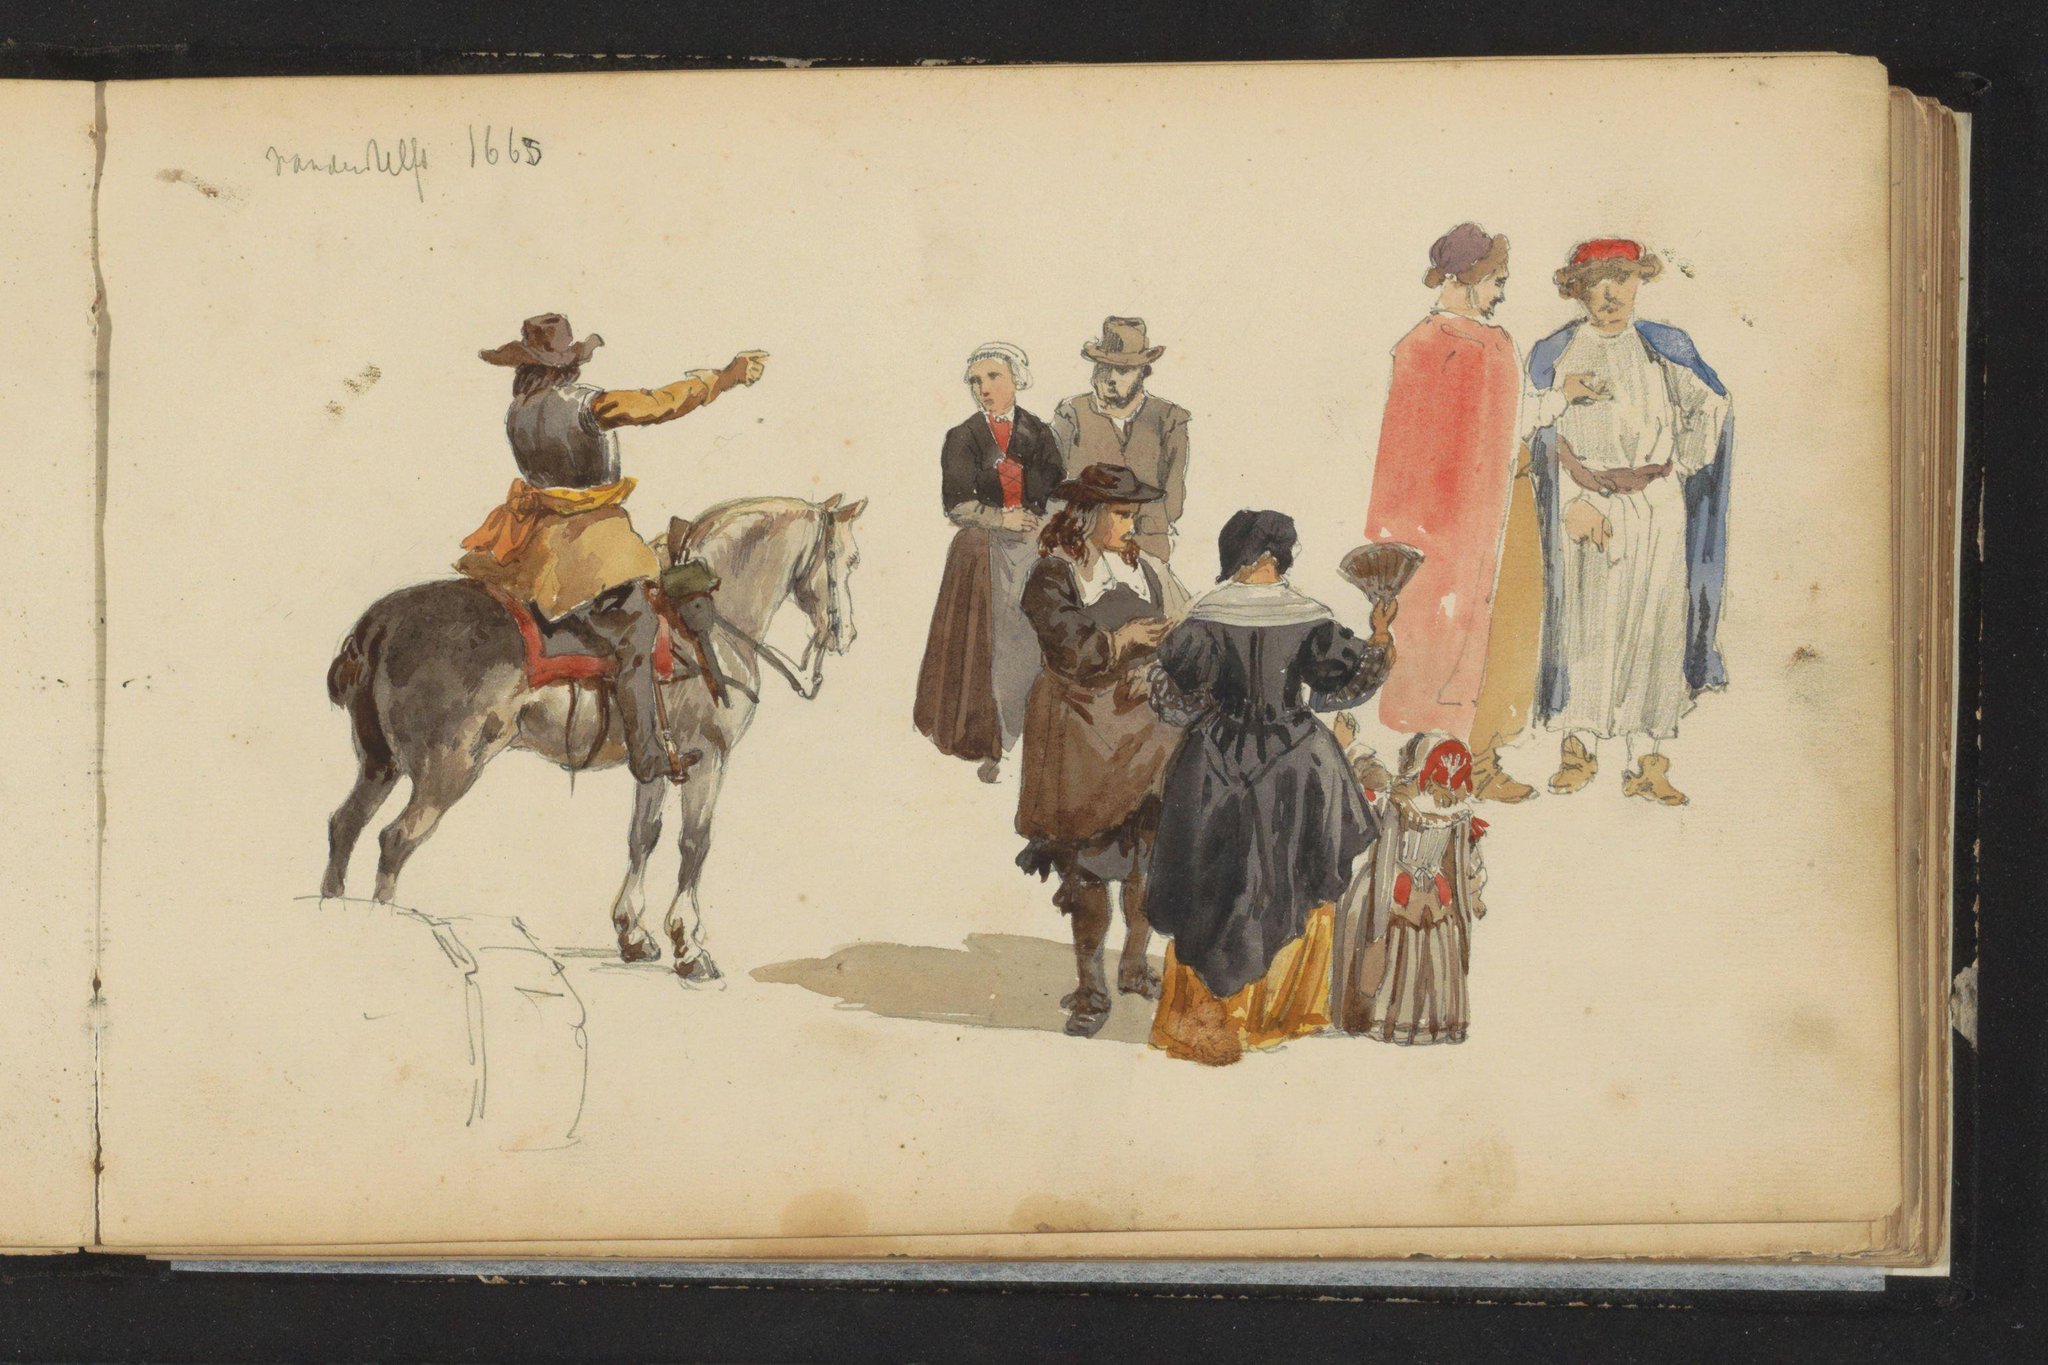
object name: sketchbook leaf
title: Figuren in zeventiende-eeuwse kleding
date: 1846-1882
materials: paper, pencil, watercolor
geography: netherlands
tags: clothes, costume (+ children's clothes), adult woman, adult man, child, clothes, costume (+ women's clothes), clothes, costume (+ men's clothes)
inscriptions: annotation: ‘Van der Ulft 1665[?]’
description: Figuren in zeventiende-eeuwse kleding. Links een ruiter. Blad 35 uit een schetsboek met 91 bladen.